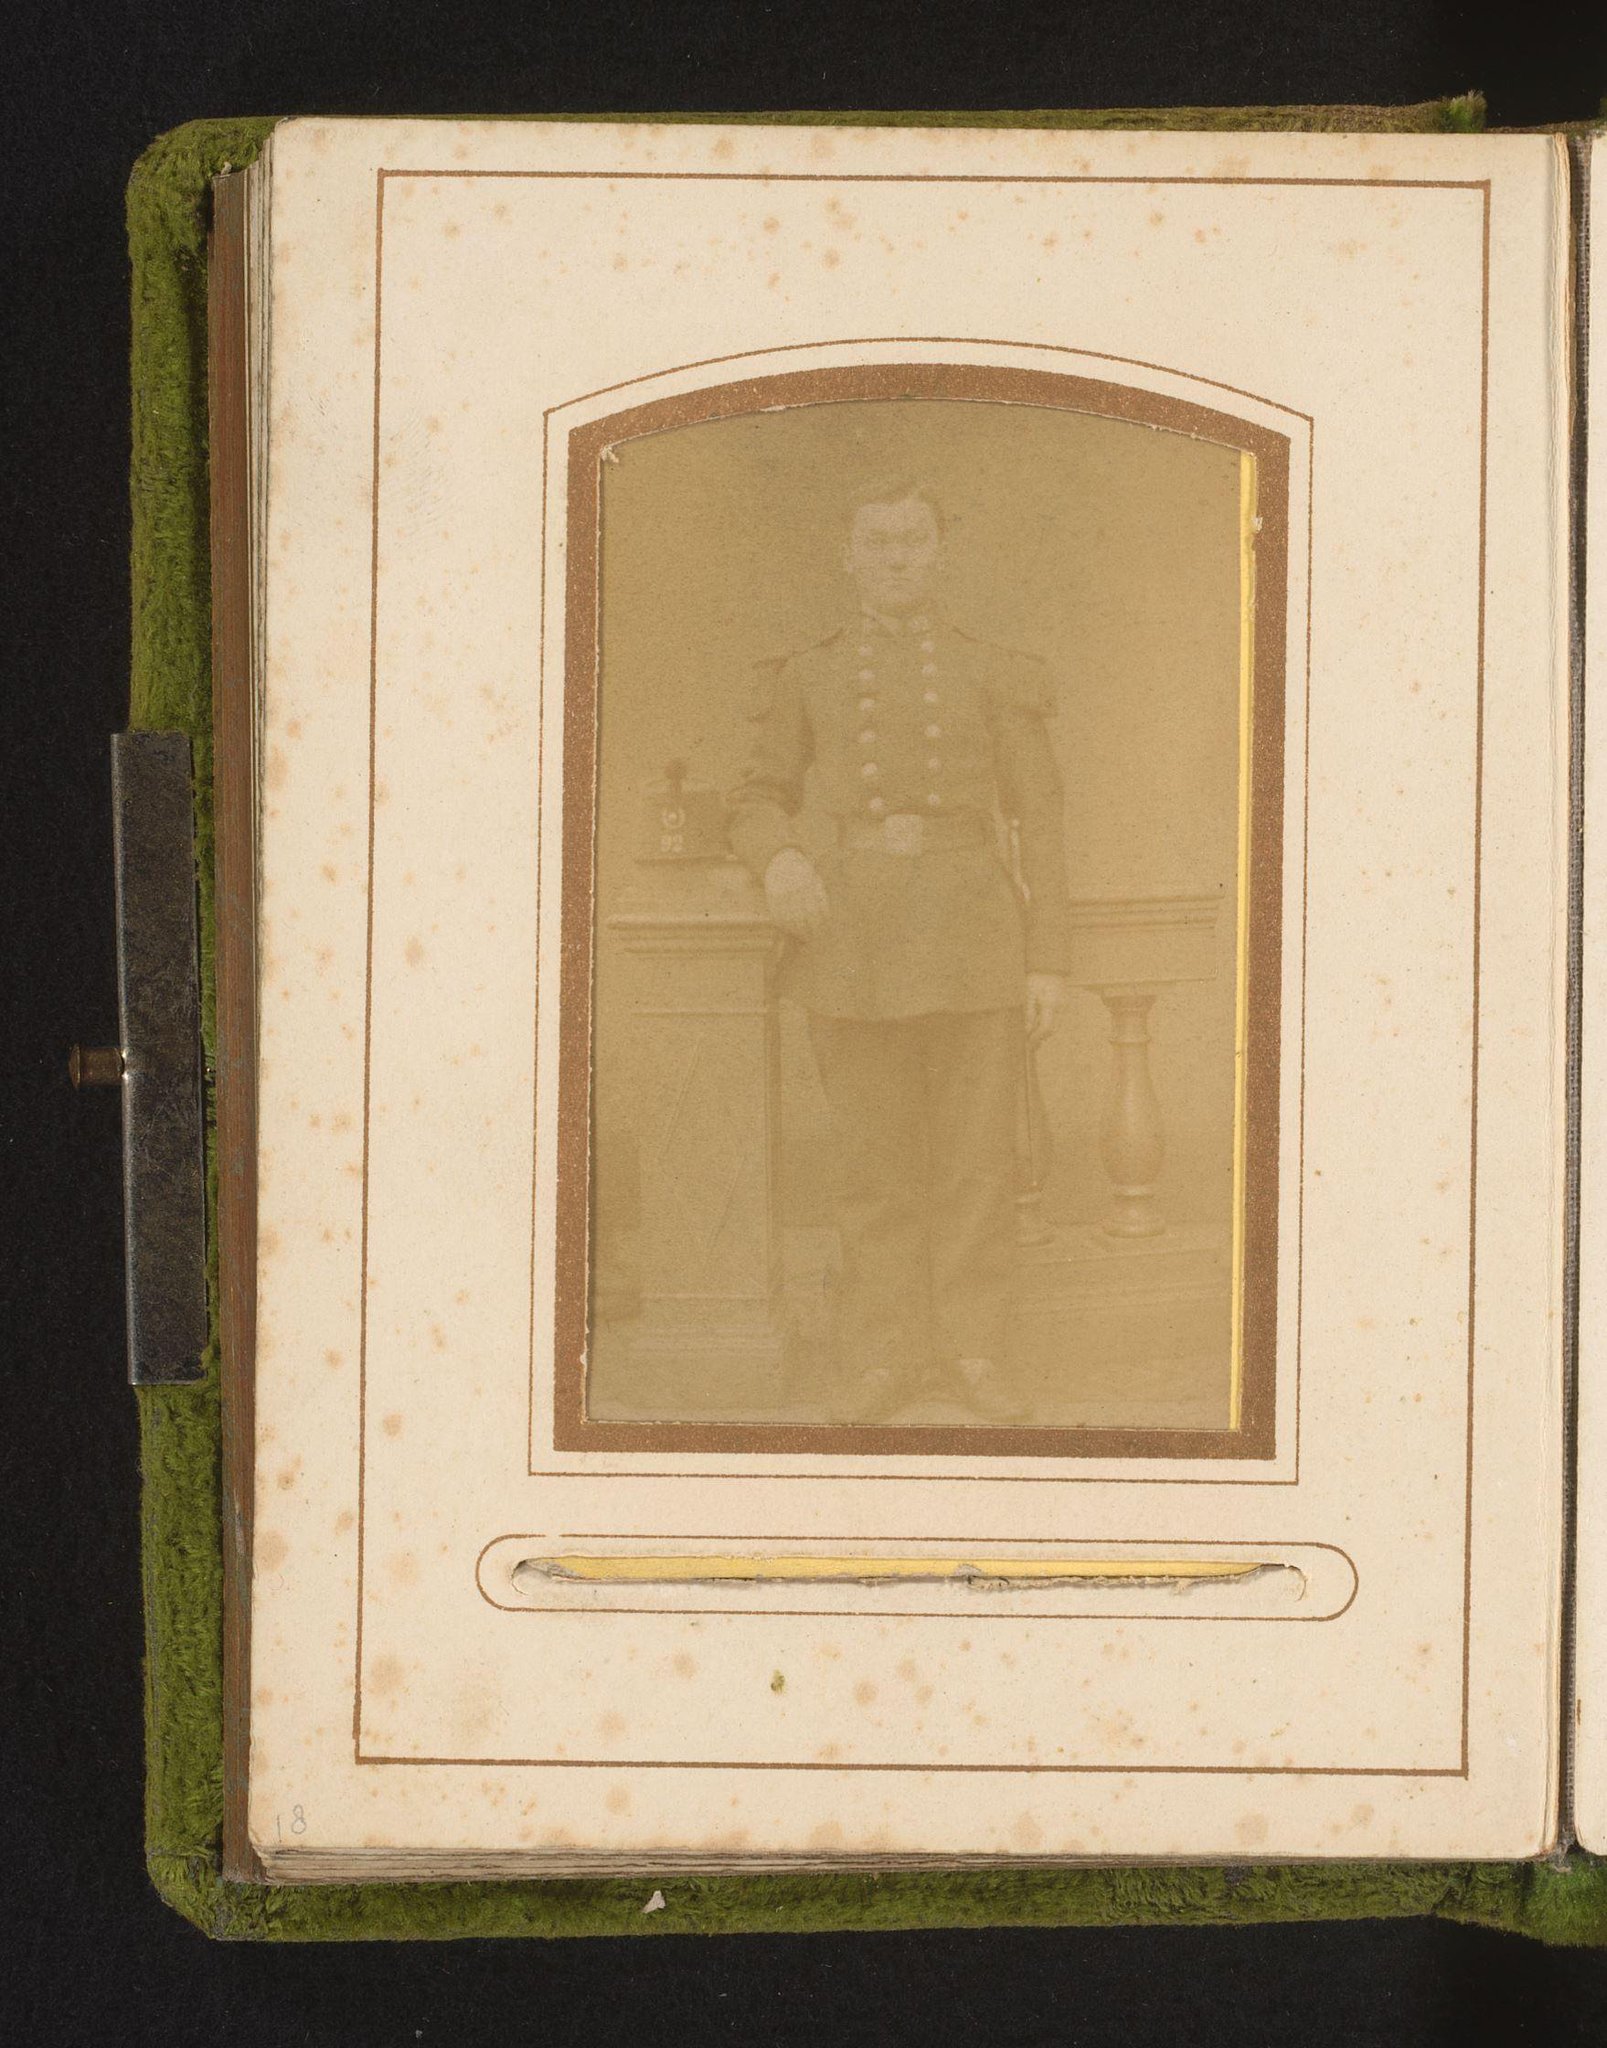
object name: carte de visite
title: Portret van een man in uniform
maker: Anonymous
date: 1860-1900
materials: cardboard, photographic support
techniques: albumen print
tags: standing figure, adult man, historical persons, (military) uniforms